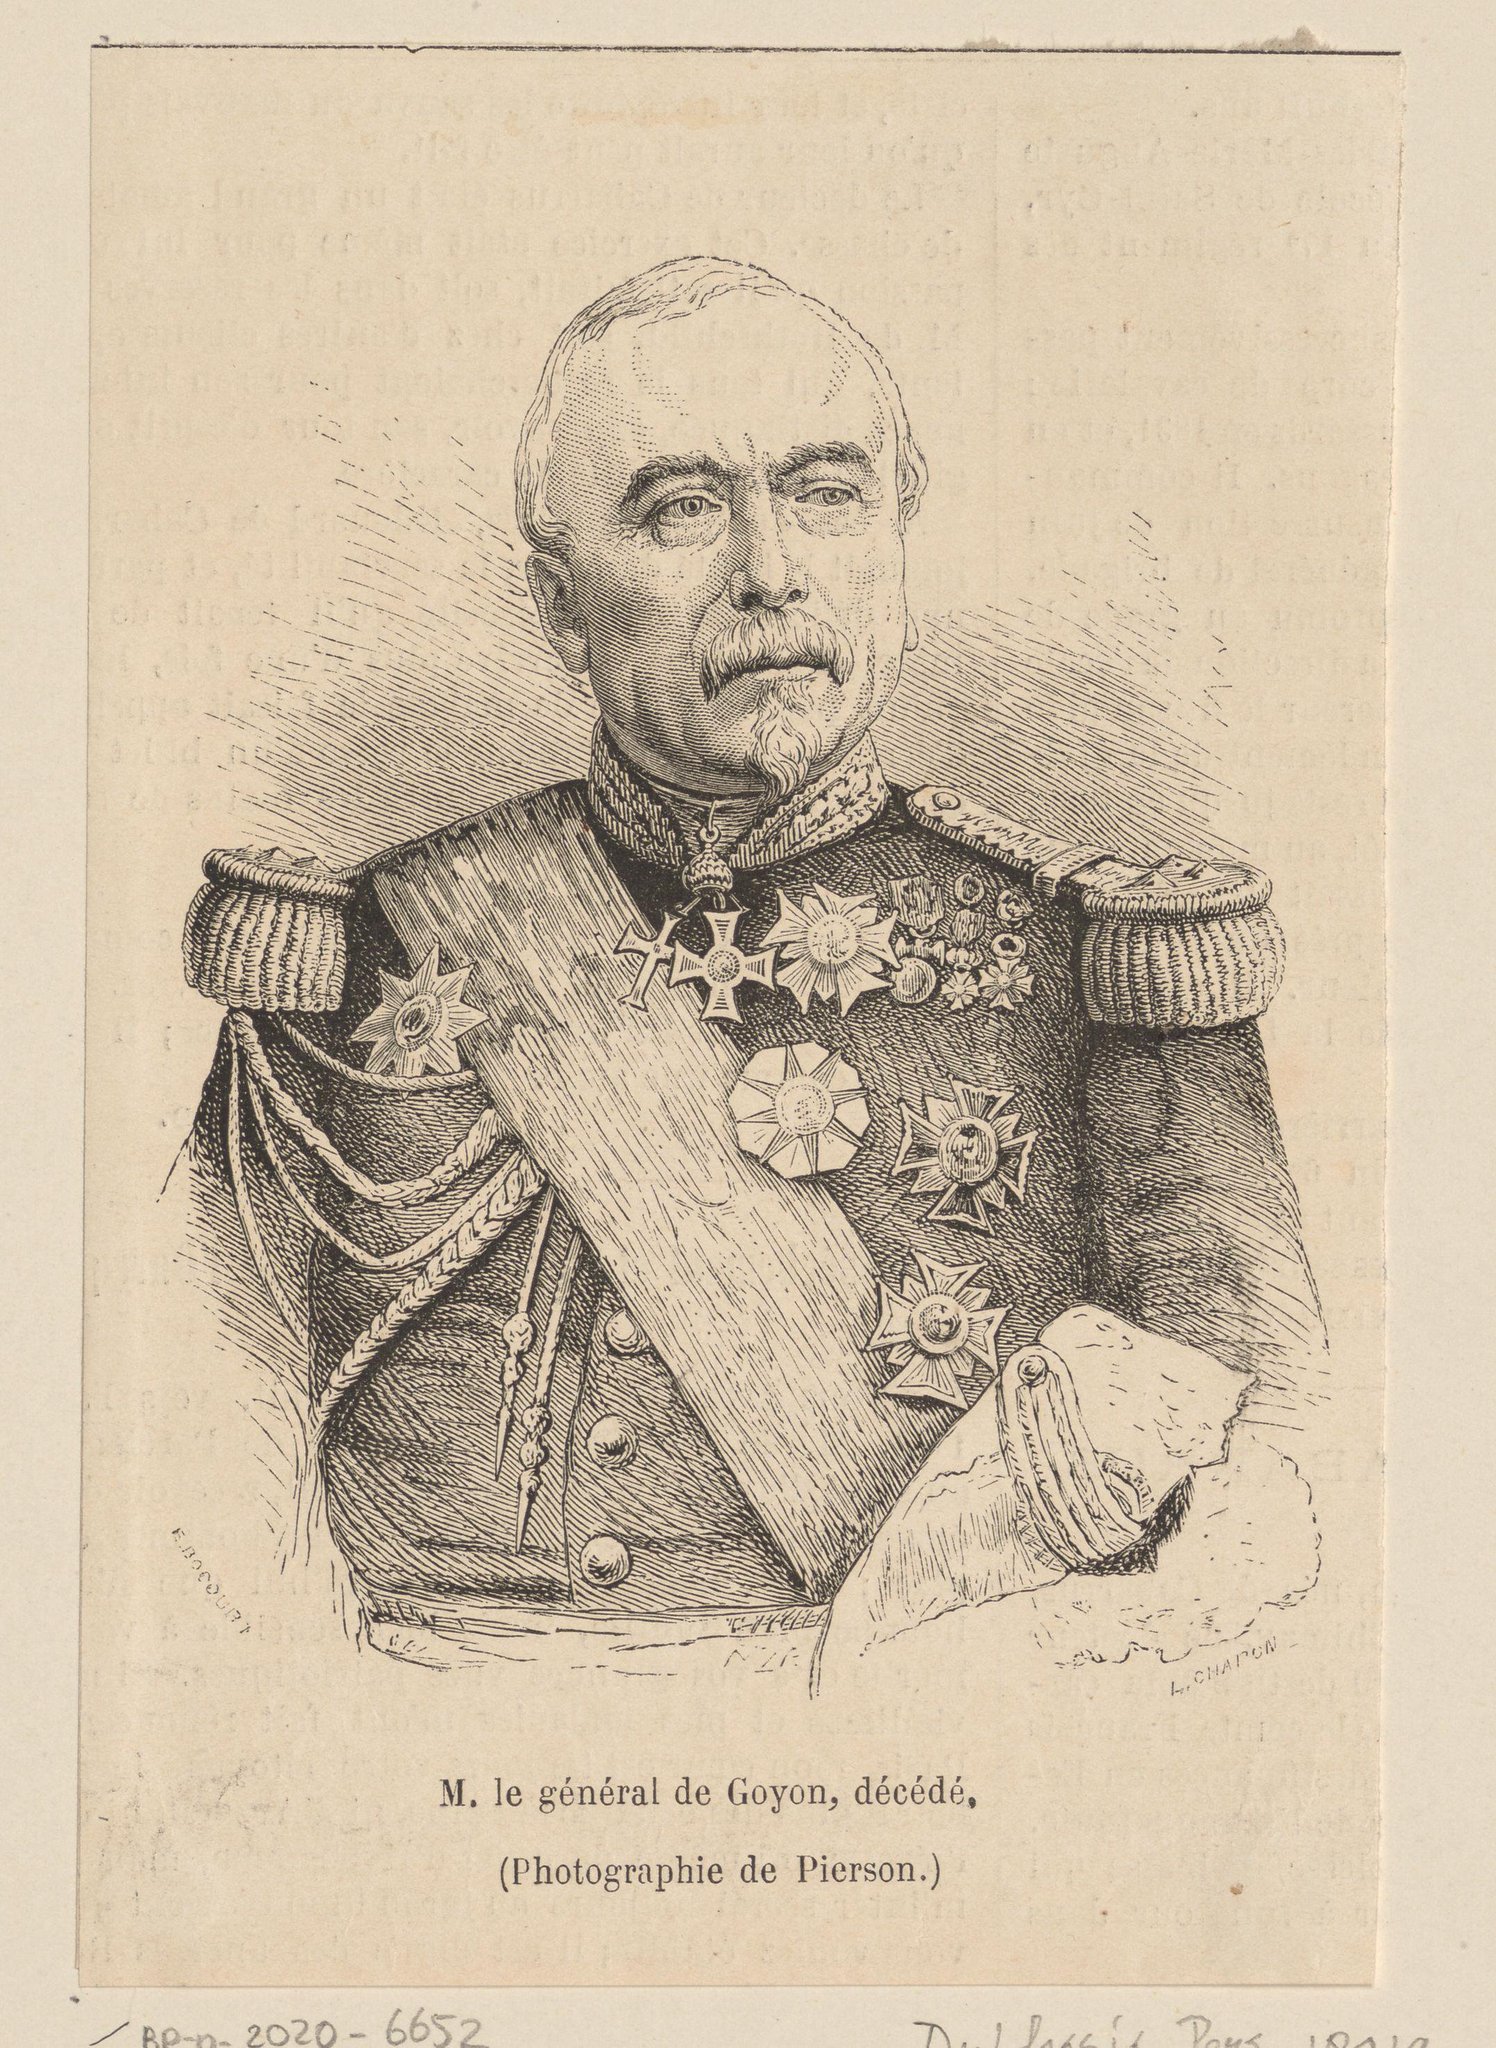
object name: print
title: Portret van Charles de Goyon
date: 1870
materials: paper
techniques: letterpress printing, engraving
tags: paris, politician, historical persons, officer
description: Prent uit: Le Monde illustré 14 (1870), nr. 695, 28 mei 1870.